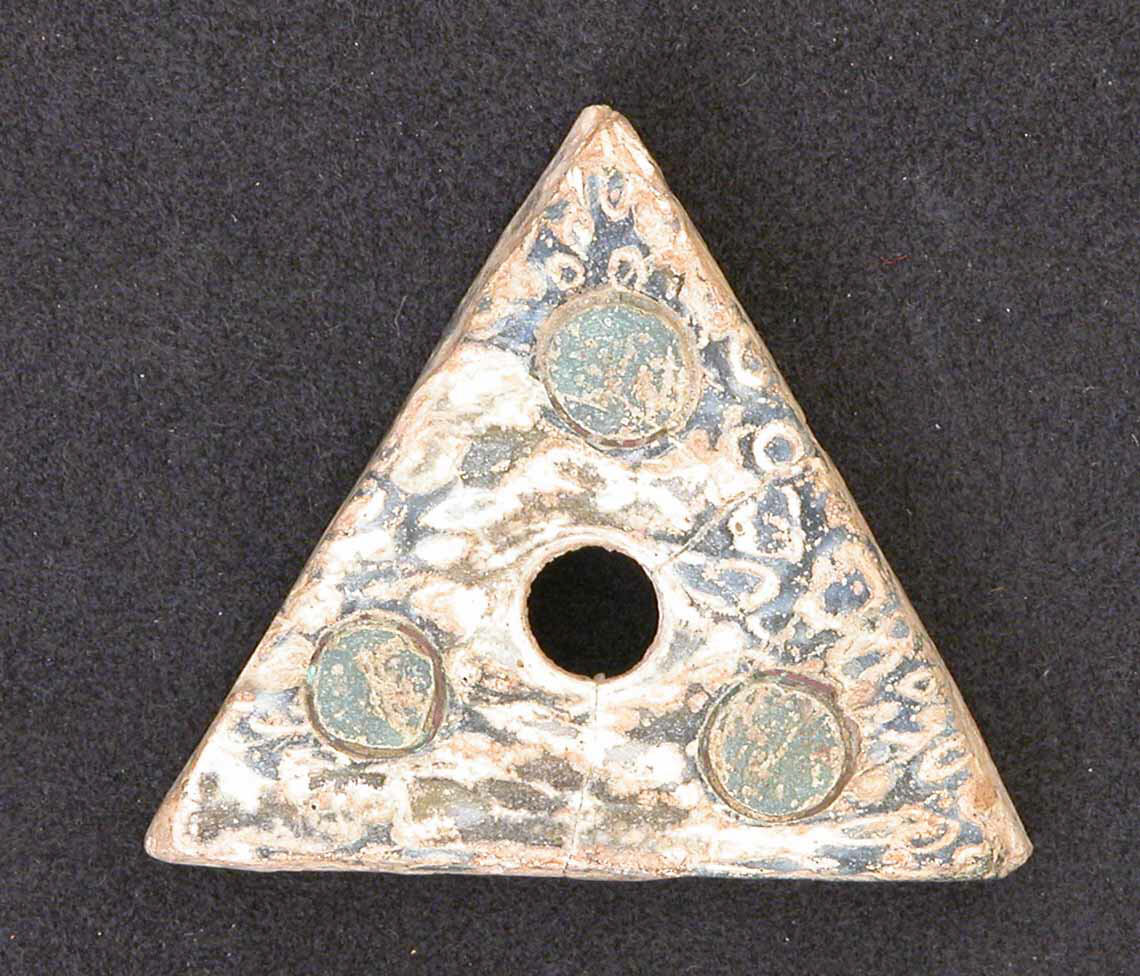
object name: pendant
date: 801-1200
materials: glass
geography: iraq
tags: pendants